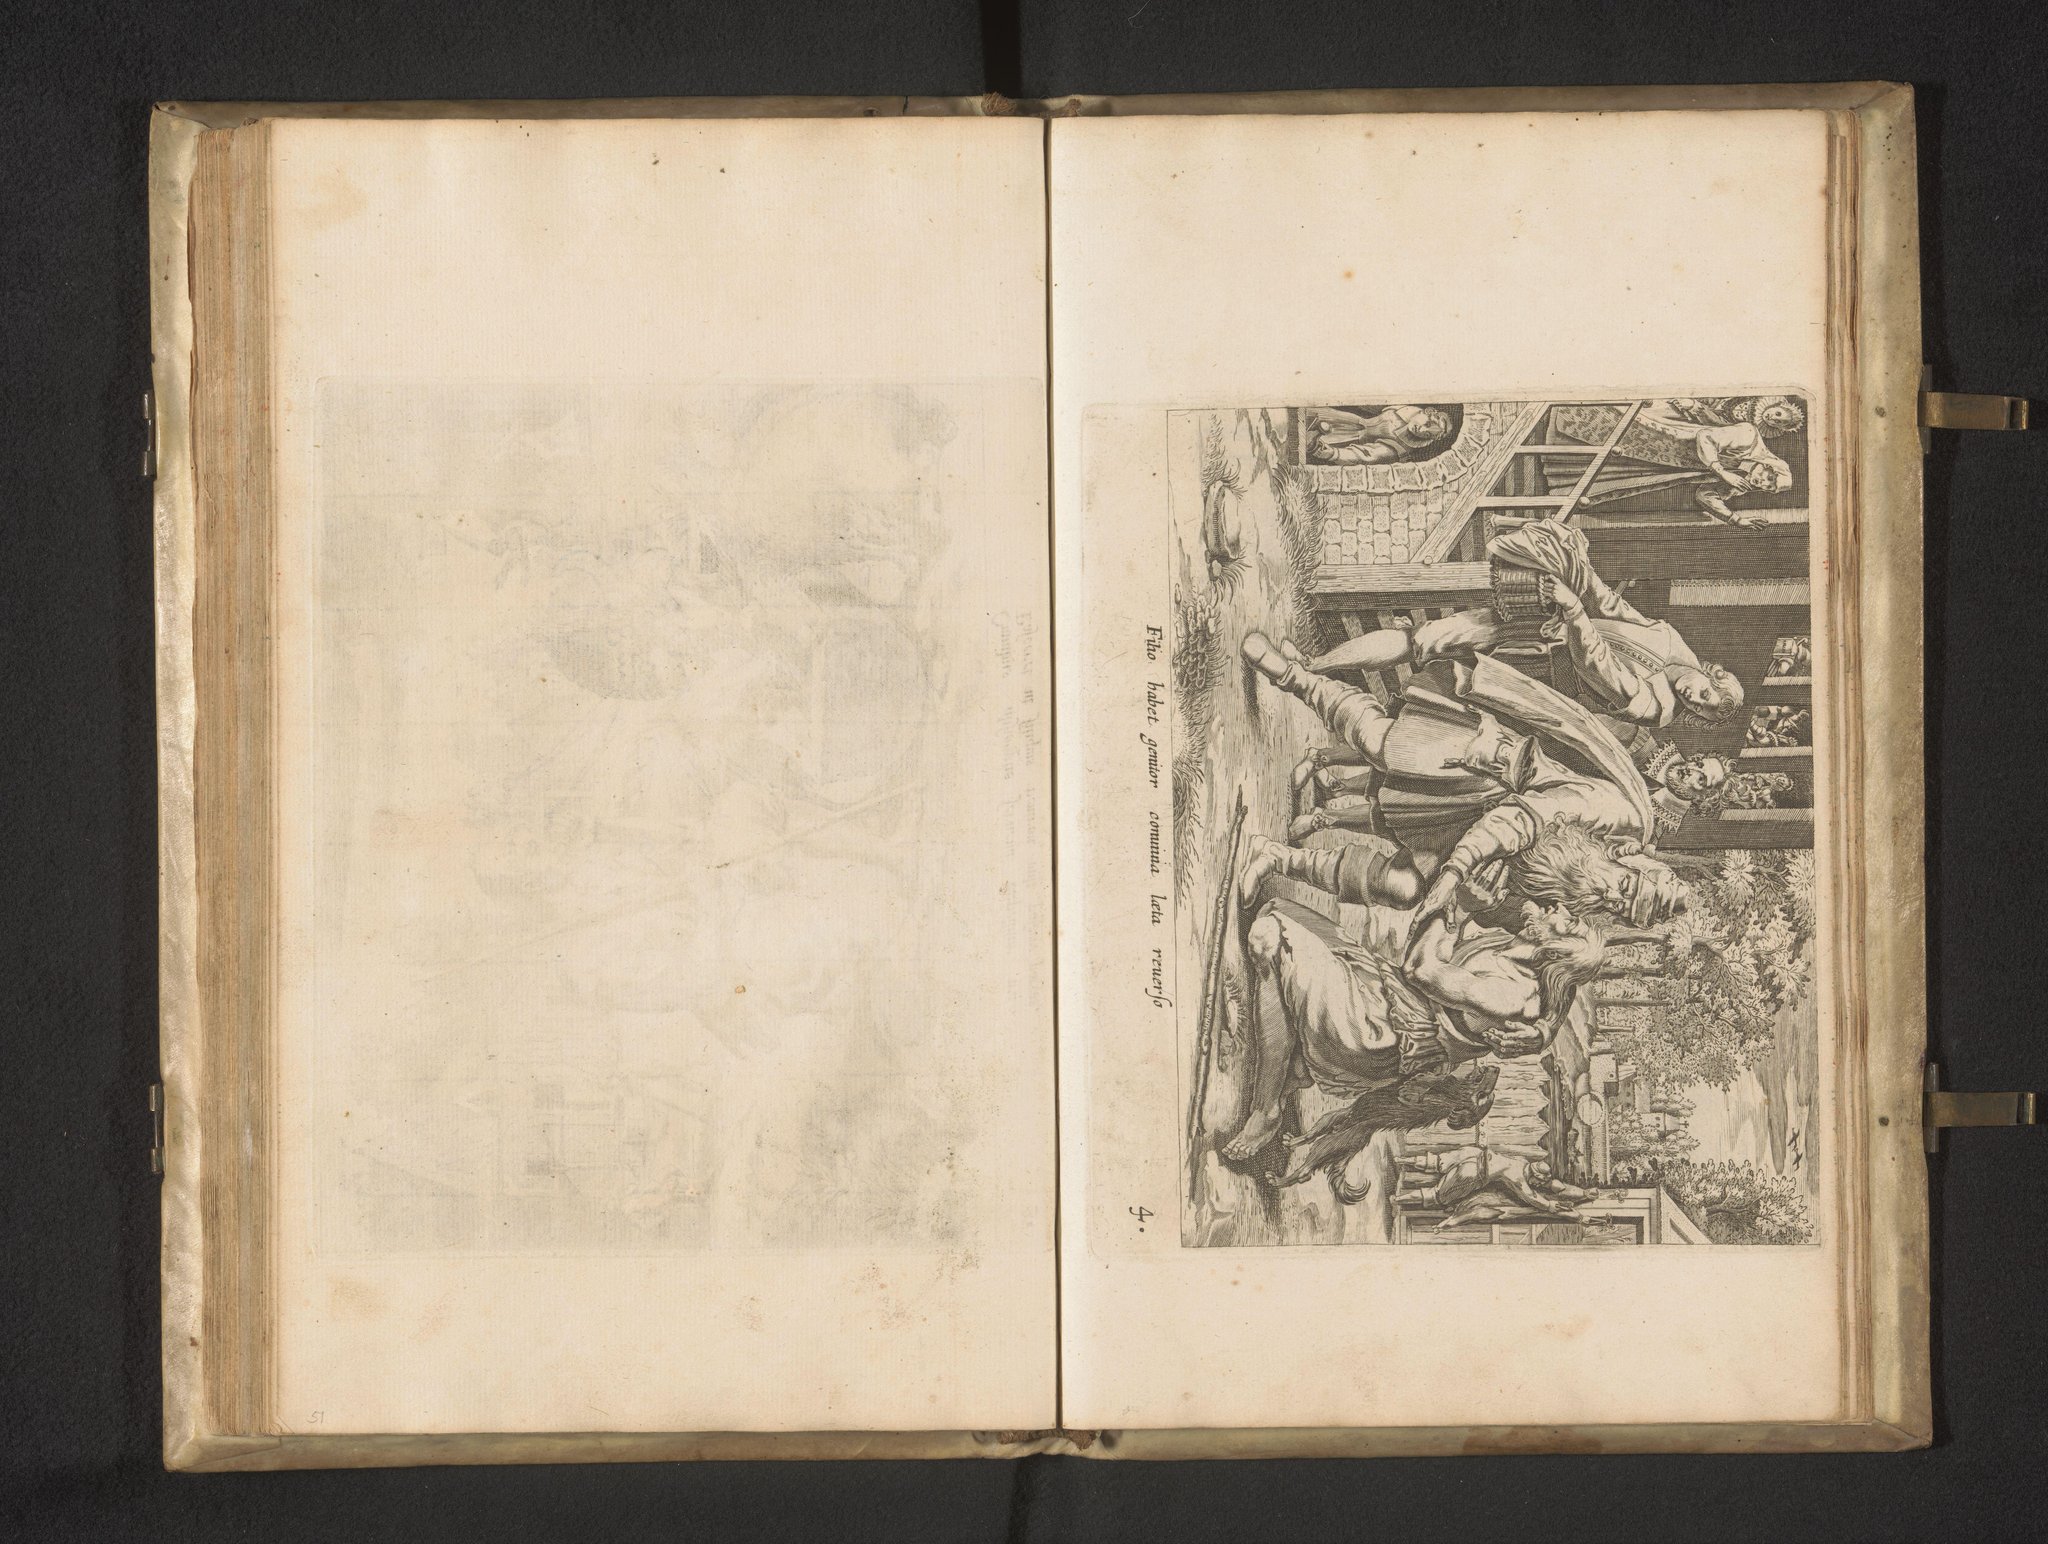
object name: print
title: De terugkeer van de verloren zoon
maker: frederik de wit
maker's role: print maker, printer, publisher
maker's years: 1629-1706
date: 1648-1706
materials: paper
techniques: engraving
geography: amsterdam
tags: the prodigal son returns home, where his father awaits him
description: De terugkeer van de verloren zoon. Onderdeel van een serie van 4 prenten van het verhaal van de Verloren Zoon. Genummerd rechtsonder: 4. In de marge een regel tekst in Latijn. Onderdeel van een album met voornamelijk christelijke voorstellingen.